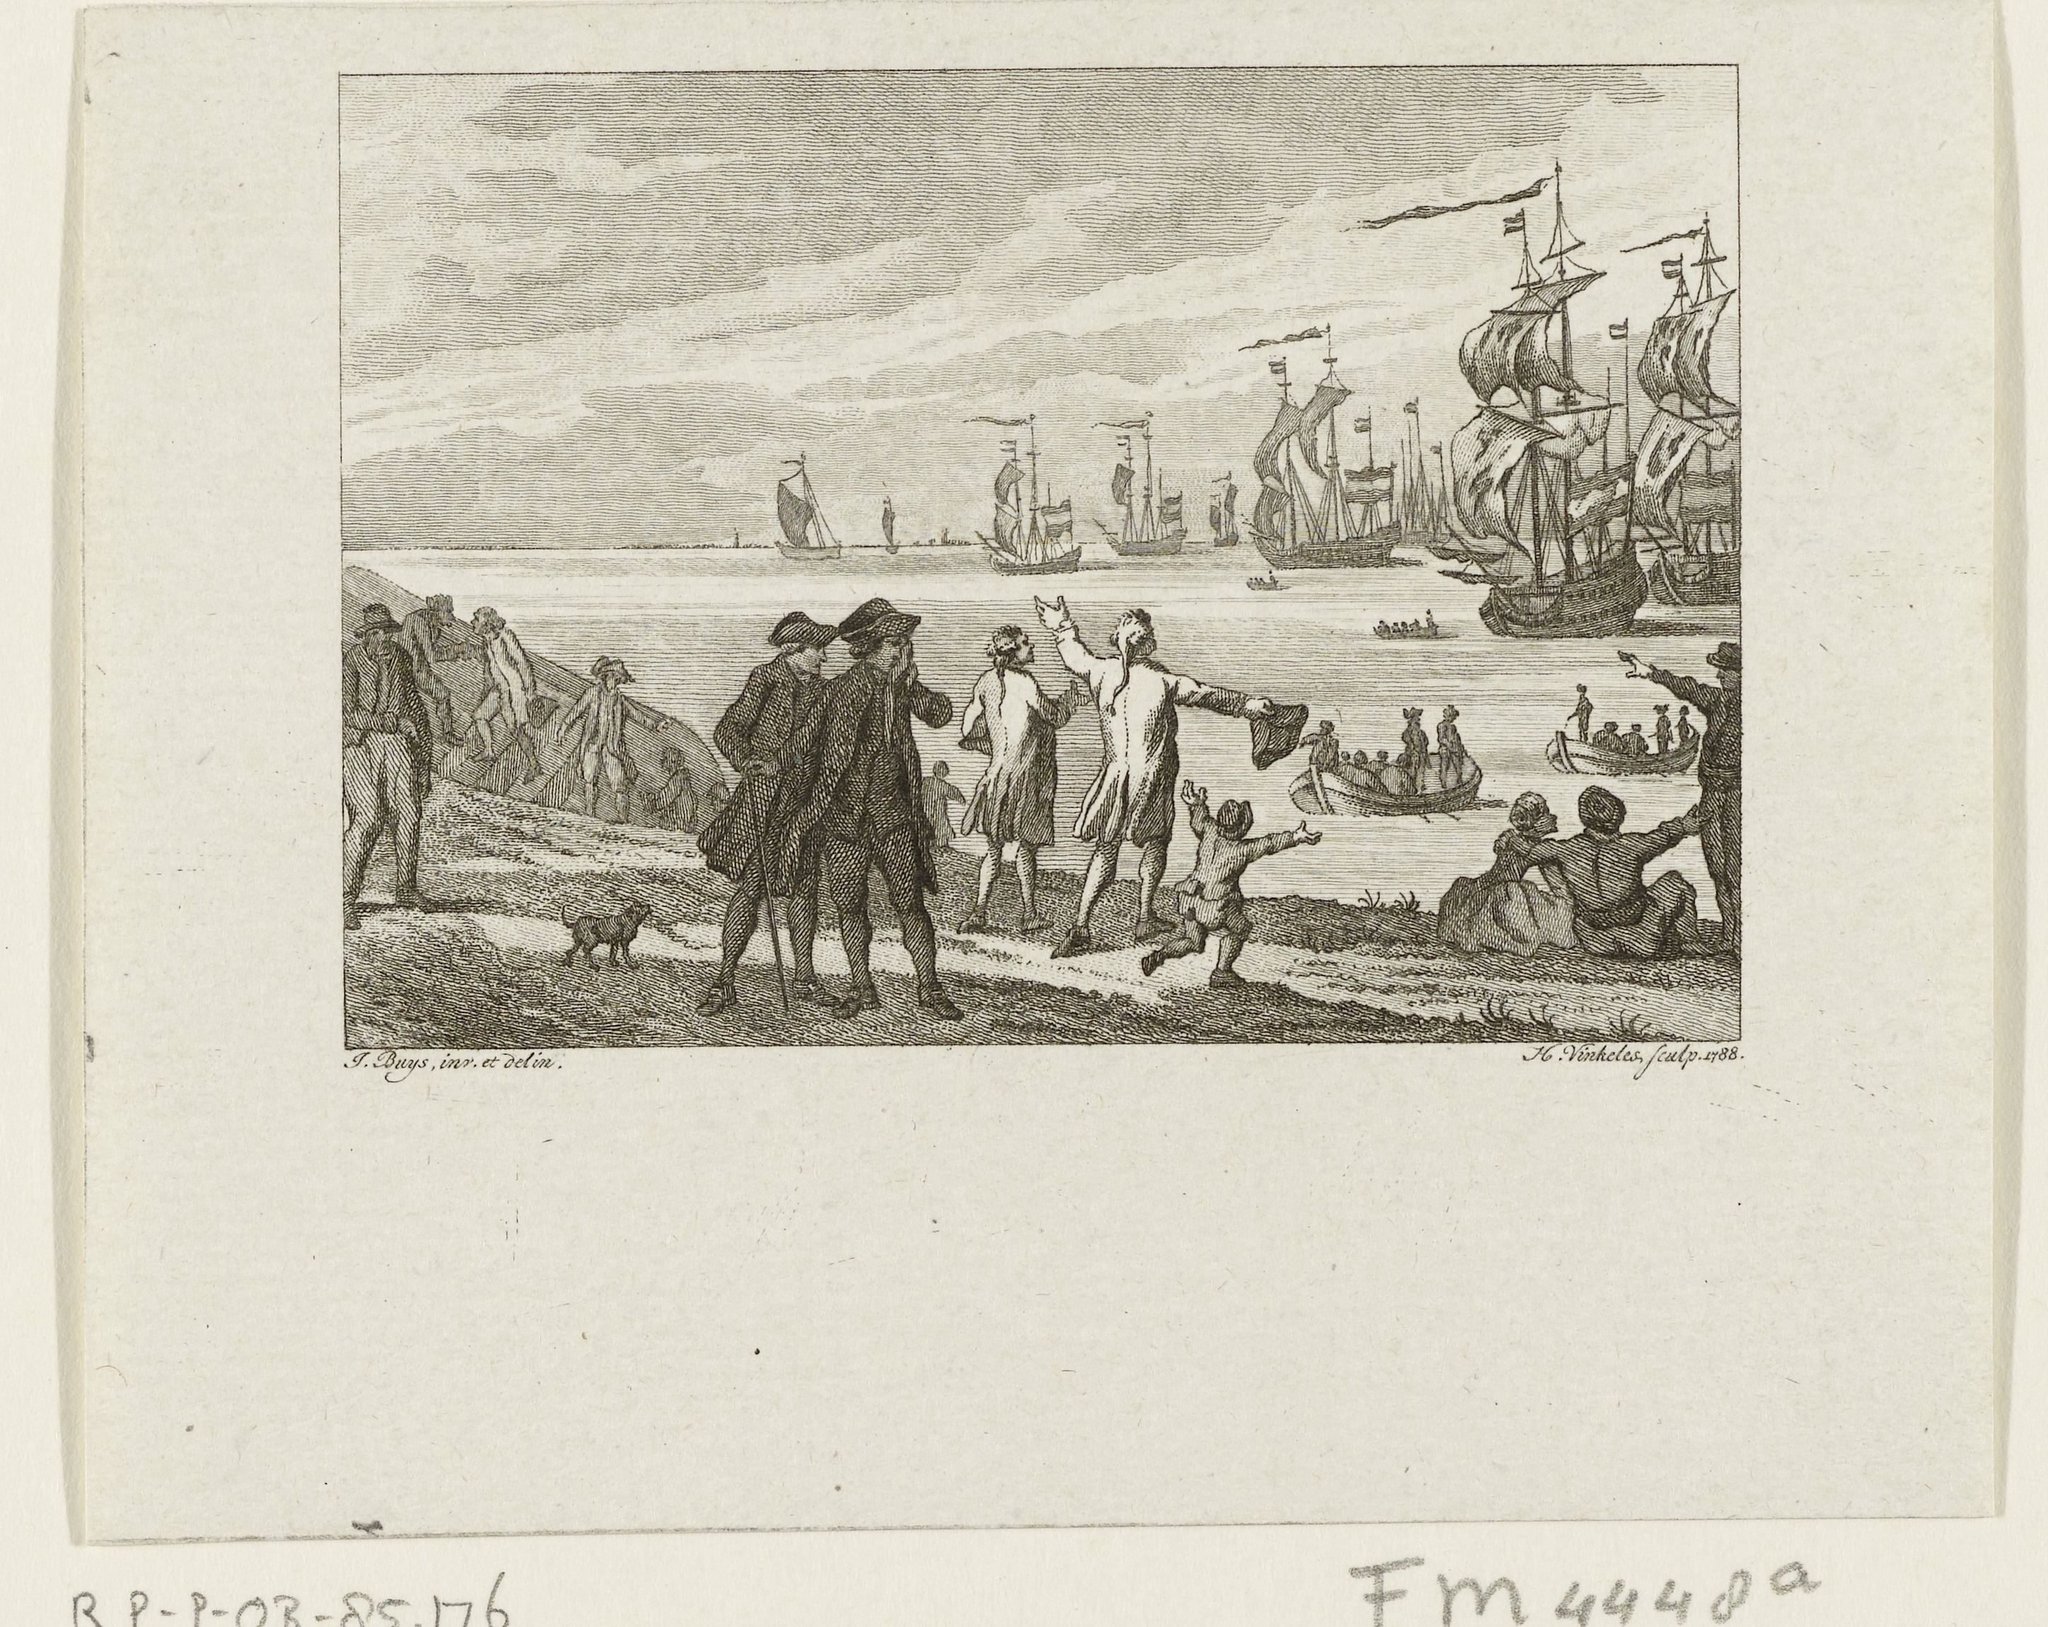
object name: history print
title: Terugkeer van de Hollandse vloot na de slag bij Doggersbank, 1781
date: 1788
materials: paper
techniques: etching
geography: northern netherlands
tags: victor (after the battle) (+ sailing-ships)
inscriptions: collector's mark: Lugt 2228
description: De terugkeer van de Hollandse vloot na de zeeslag bij Doggersbank op 5 augustus 1781 tussen de Nederlandse en de Engelse vloot. De schepen worden op de wal jubelend ontvangen.